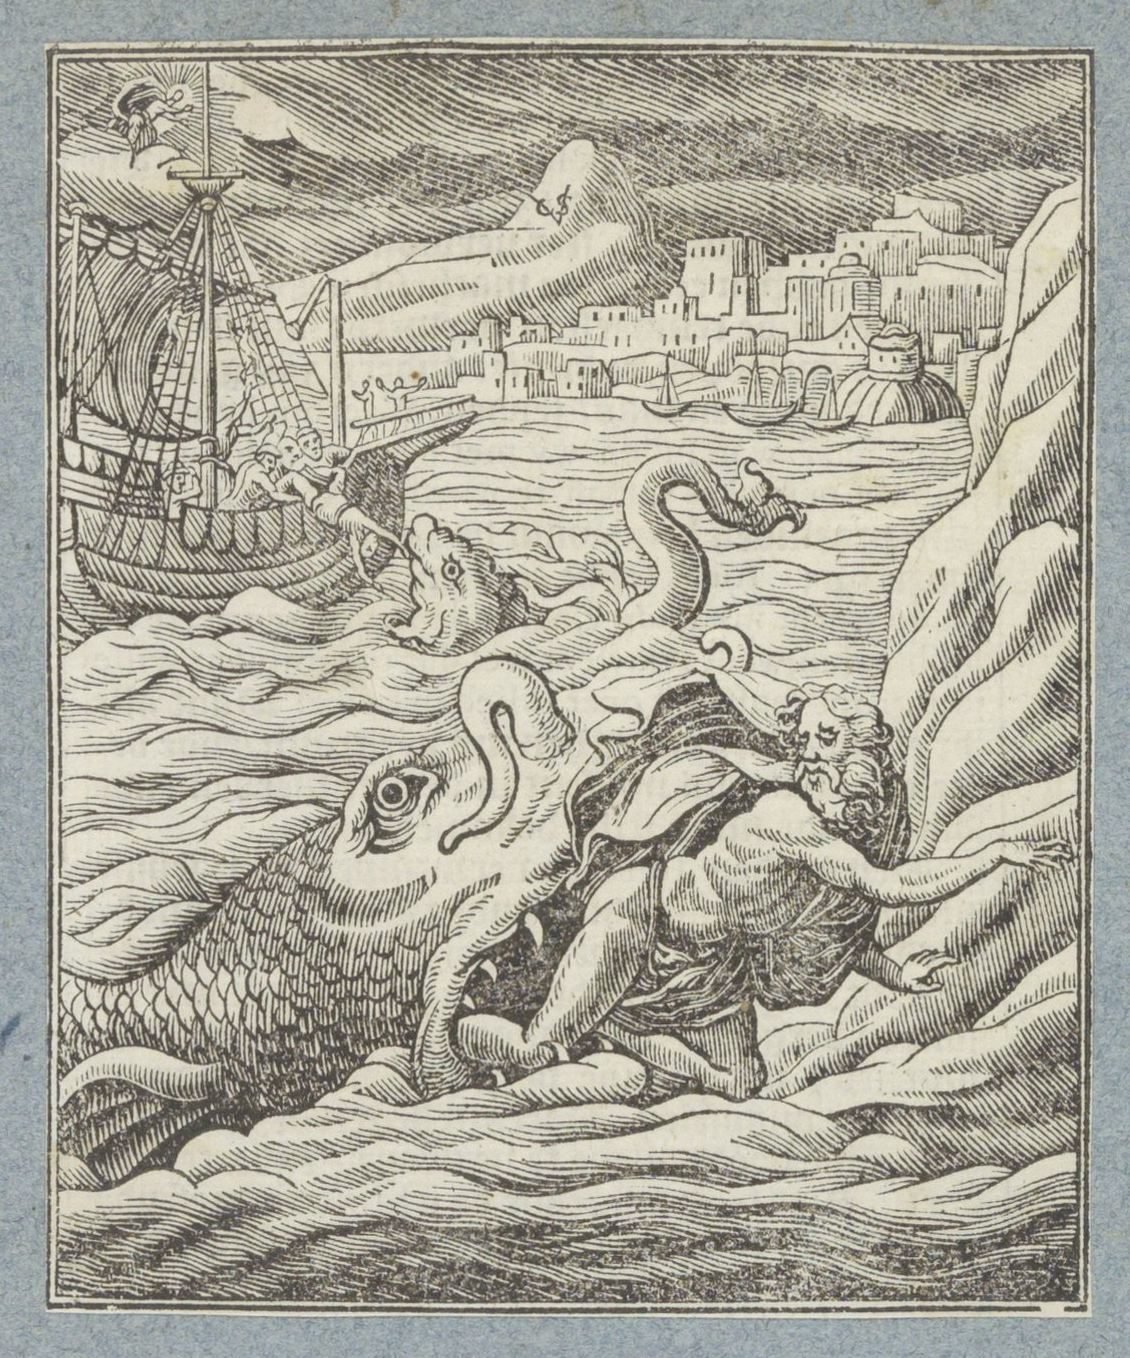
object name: print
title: Jona en de walvis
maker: pieter jacobsz. paets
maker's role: publisher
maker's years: 1587-1667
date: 1645-1646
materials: paper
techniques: letterpress printing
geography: amsterdam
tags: after a three-day sojourn in the belly of the monster jonah is cast on dry land; jonah may be shown nude and bald-headed, jonah is swallowed by a great fish, (sea)monster, whale, dolphin, or the like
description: Tijdens de zware storm wordt Jona door de vissers overboord gegooid. Hij wordt verzwolgen door een walvis. Na drie dagen en nachten in de buik van de vis overleefd te hebben spuwt de vis Jona uit op het land. De prent maakt deel uit van een album.